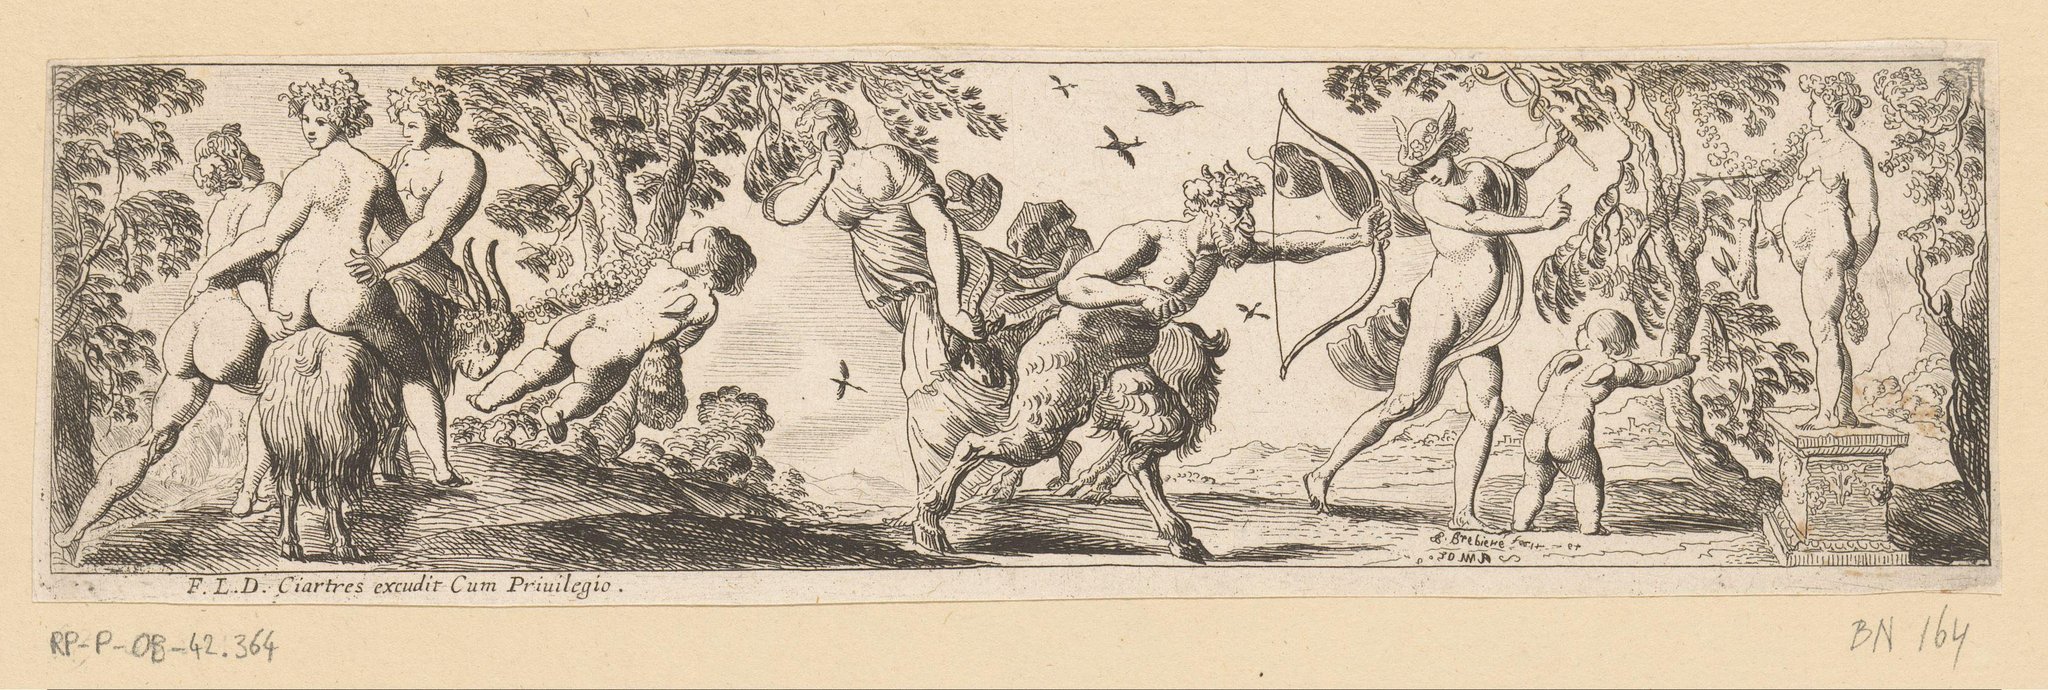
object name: print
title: Sater schiet een pijl op een beeld van Bacchus terwijl Mercurius toekijkt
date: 1617-1626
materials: paper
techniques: etching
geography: rome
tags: (story of) mercury (hermes), satyr(s) (in general), shooting with bow and arrow, archery (~ games of skill)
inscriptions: collector's mark: Lugt 240